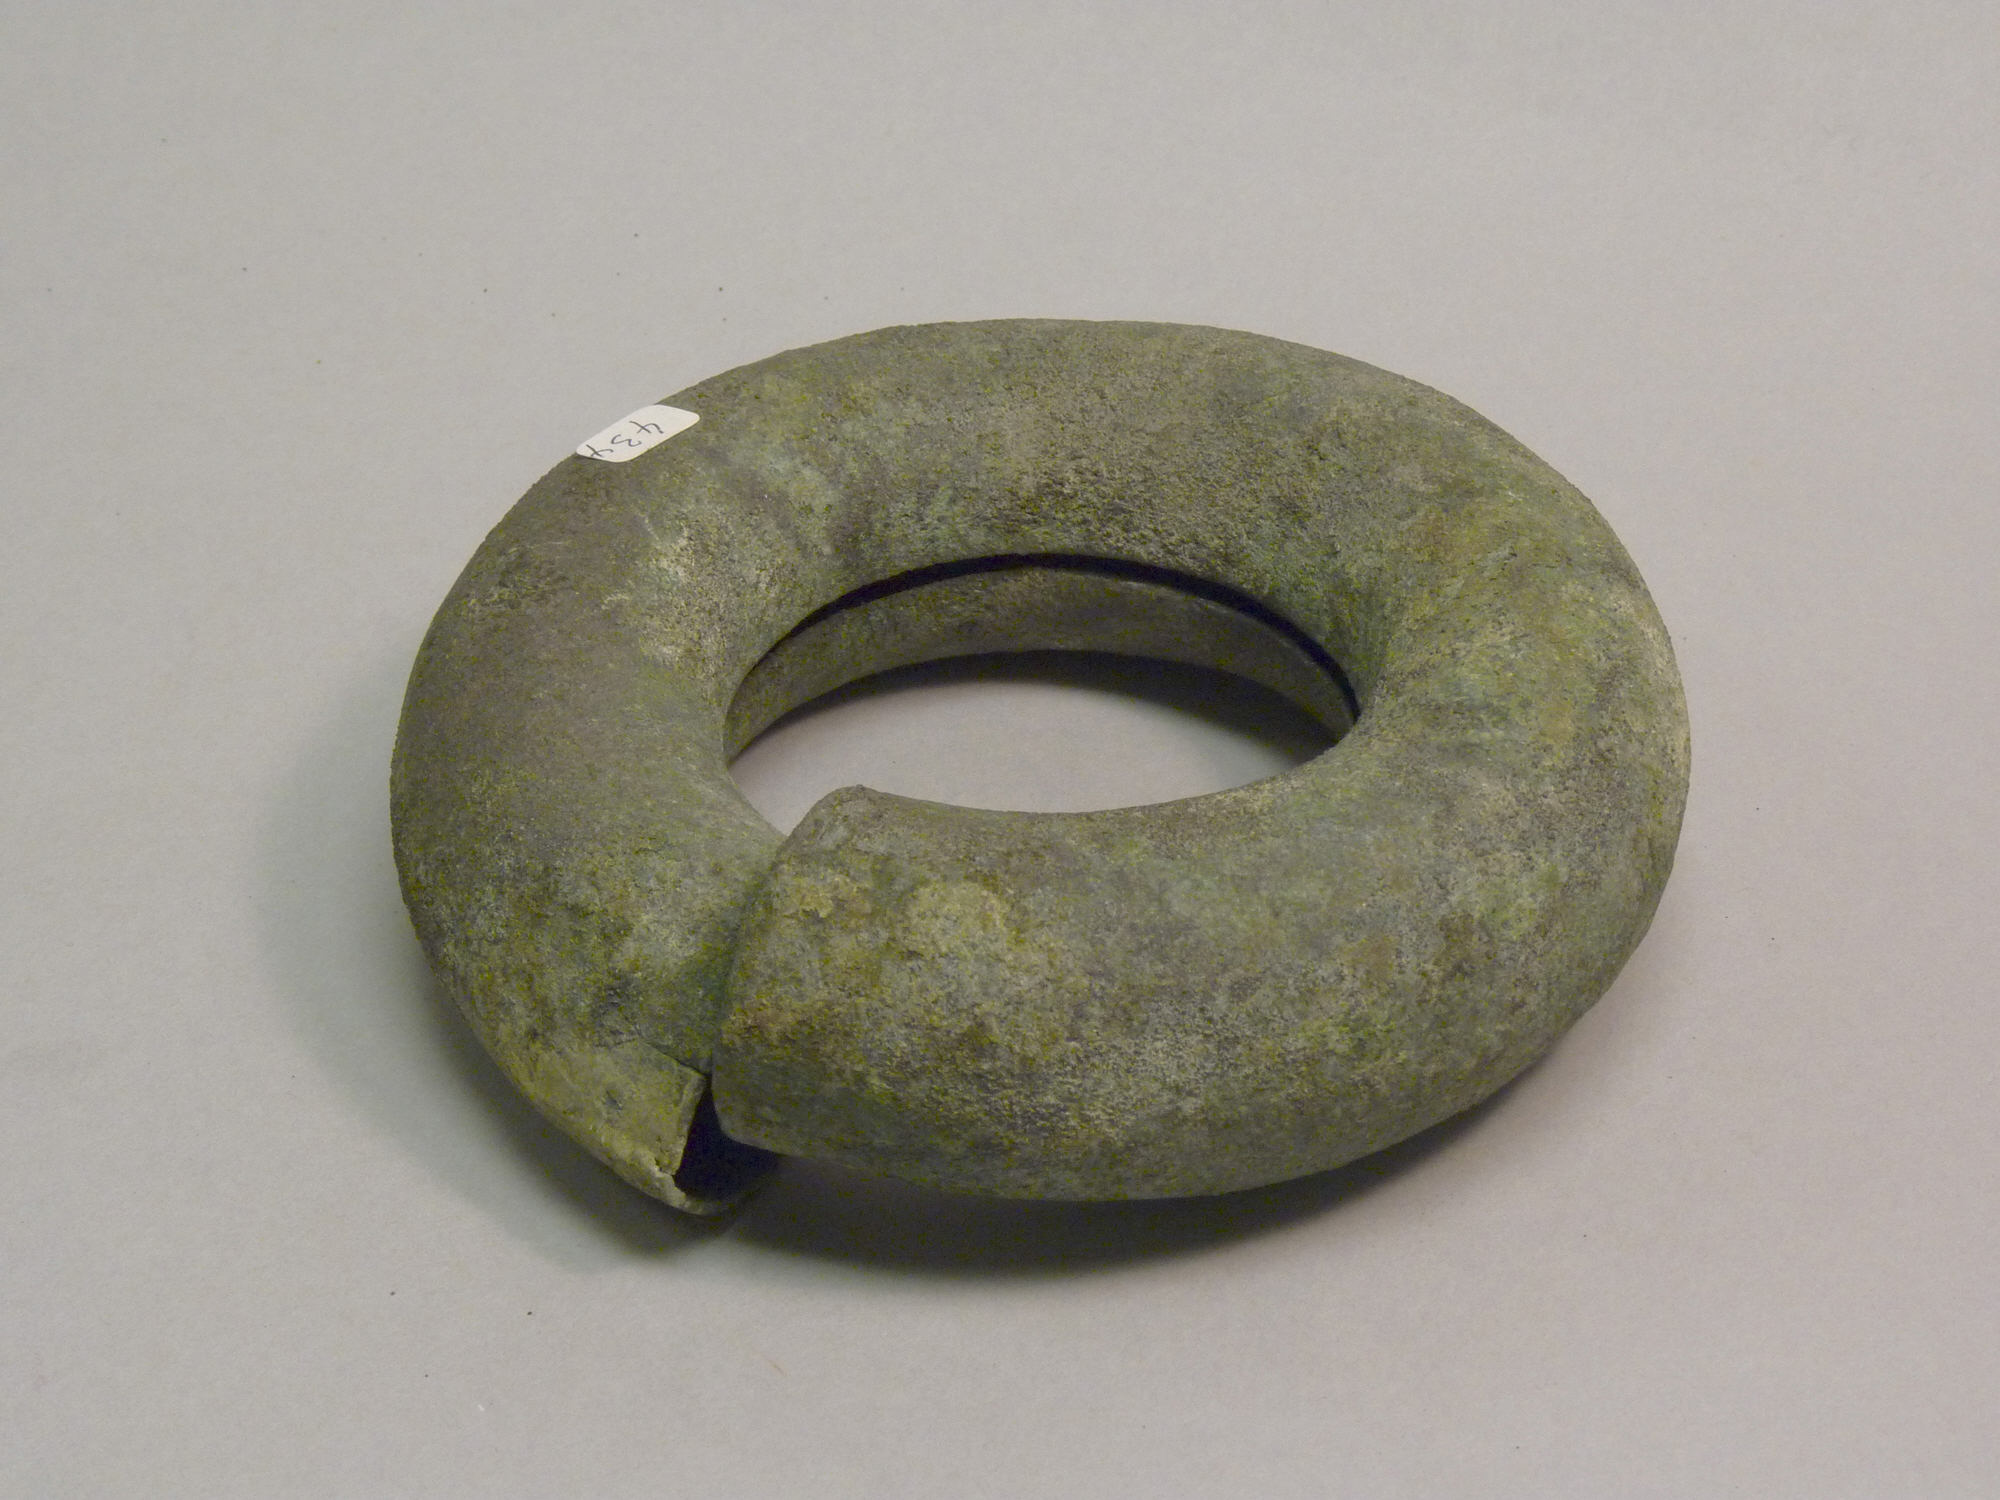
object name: bangle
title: Hollow Bangle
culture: thai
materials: bronze